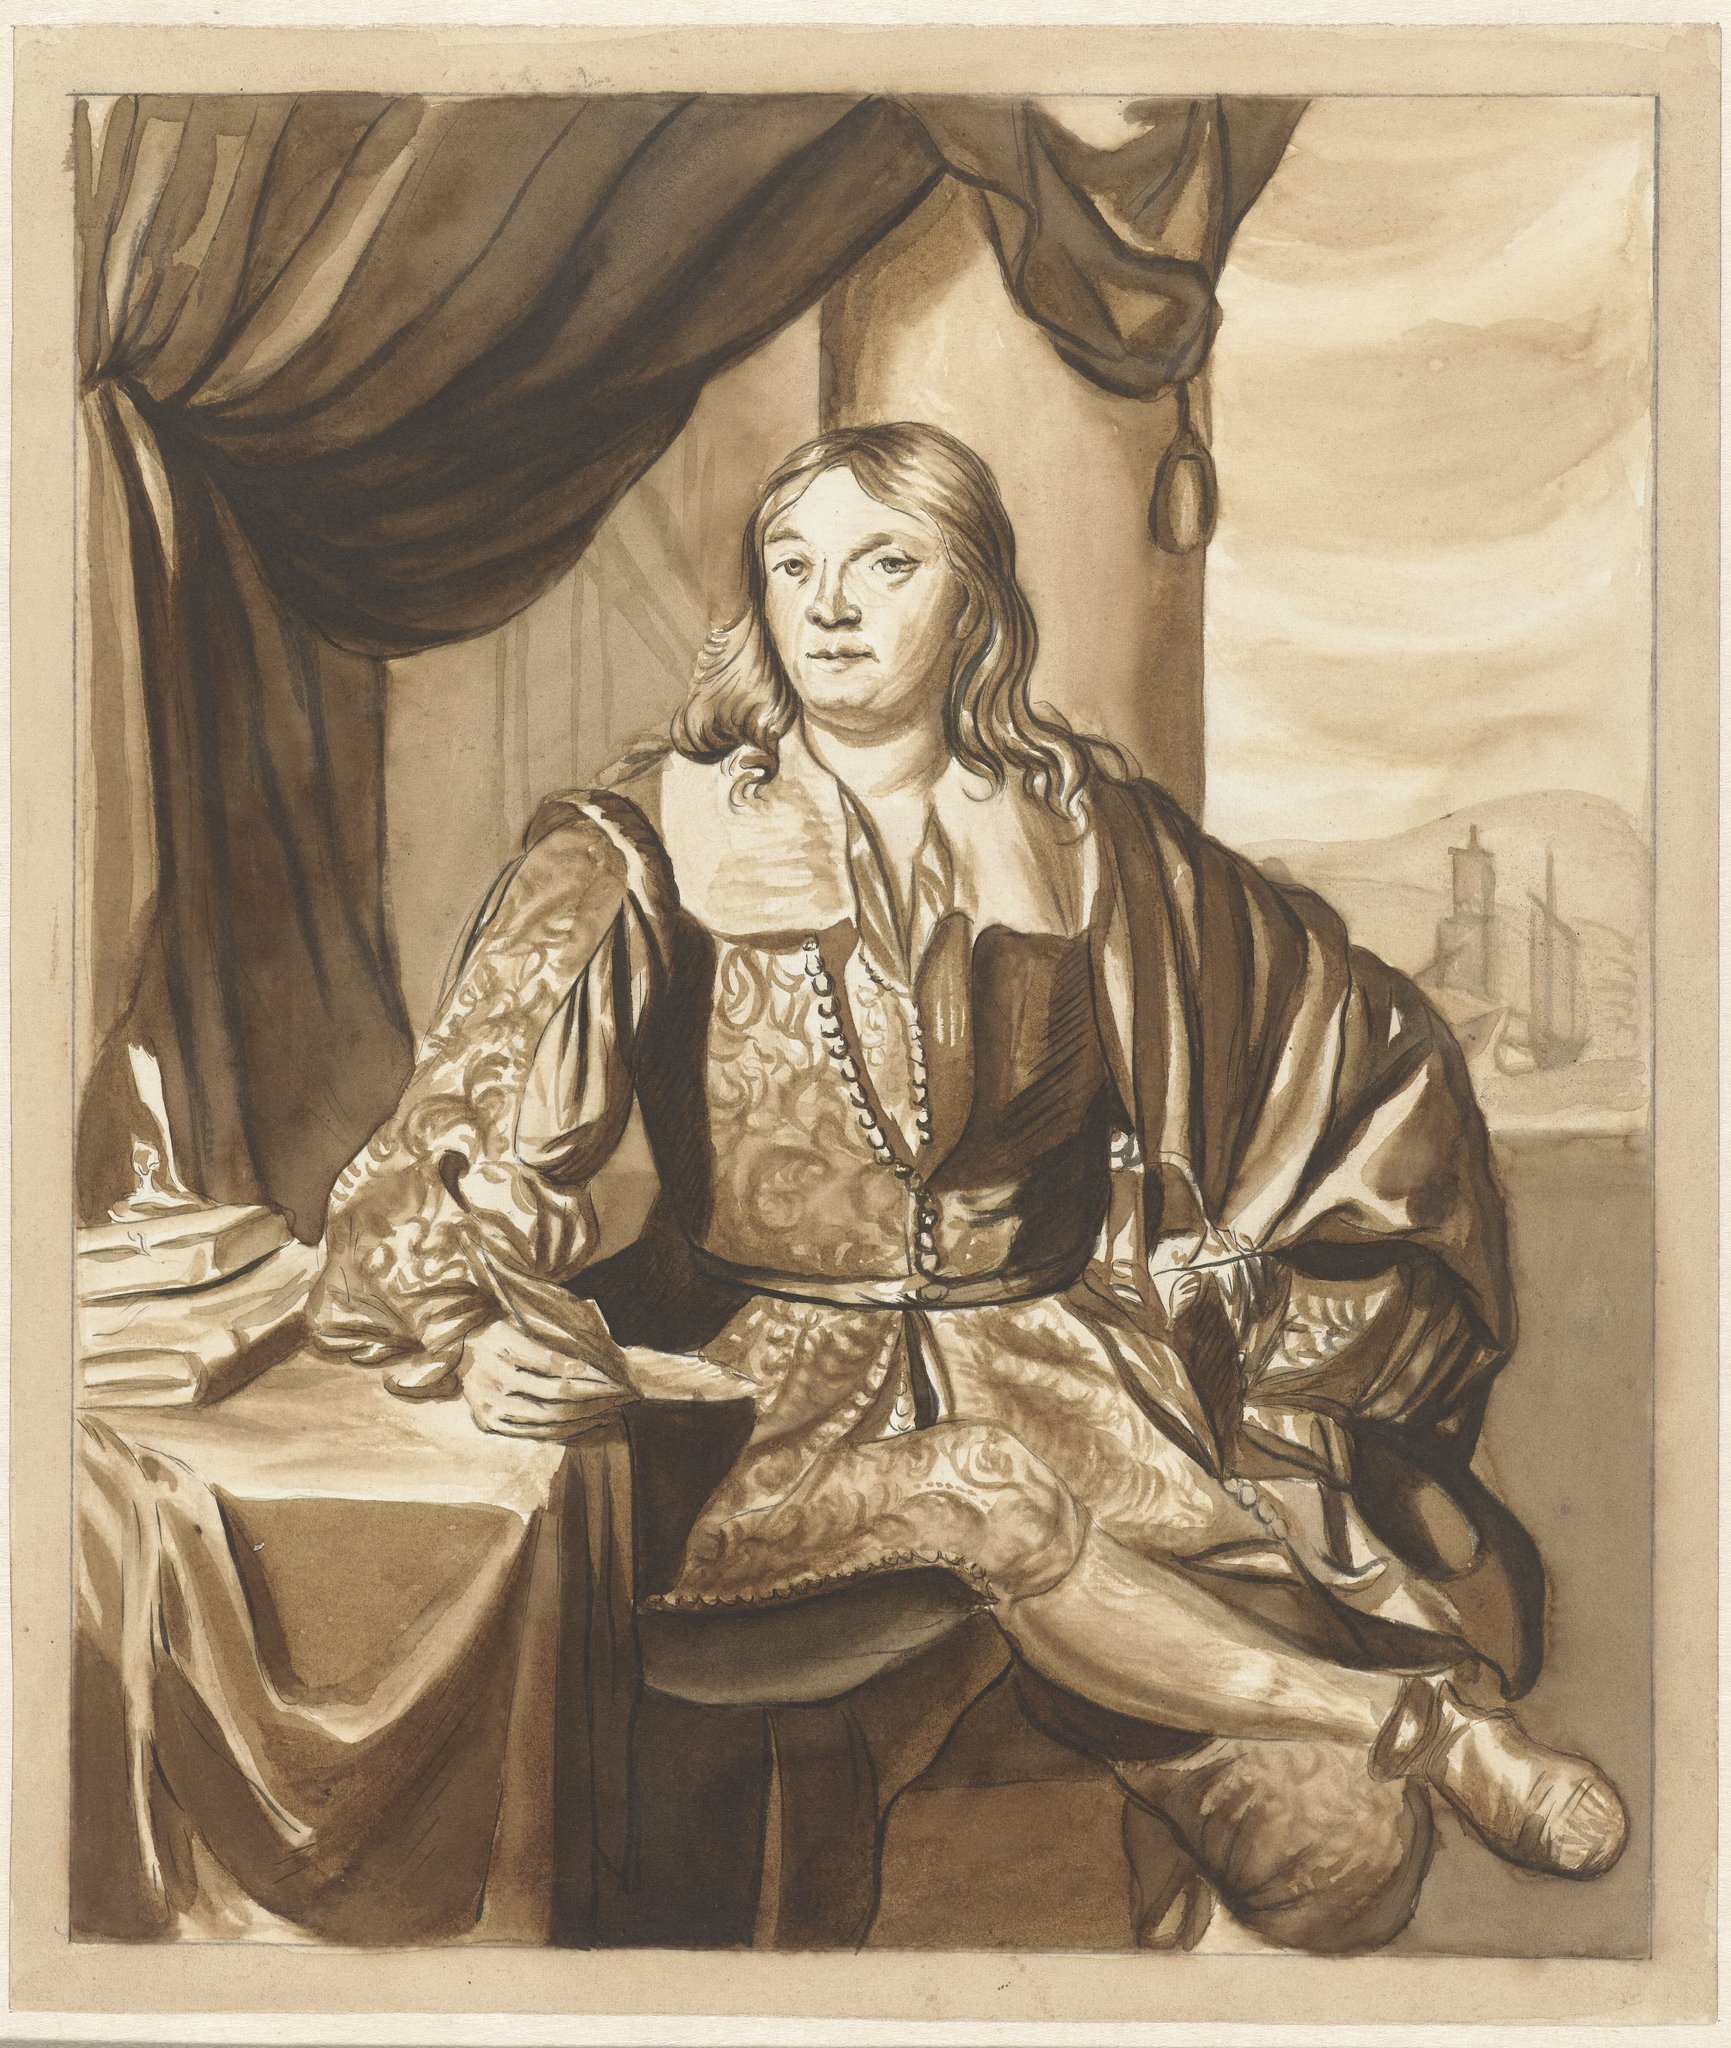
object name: drawing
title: Portret van een zittende jongeman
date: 1600-1750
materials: chalk, ink, paper, pencil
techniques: brush, pen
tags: anonymous historical person portrayed alone